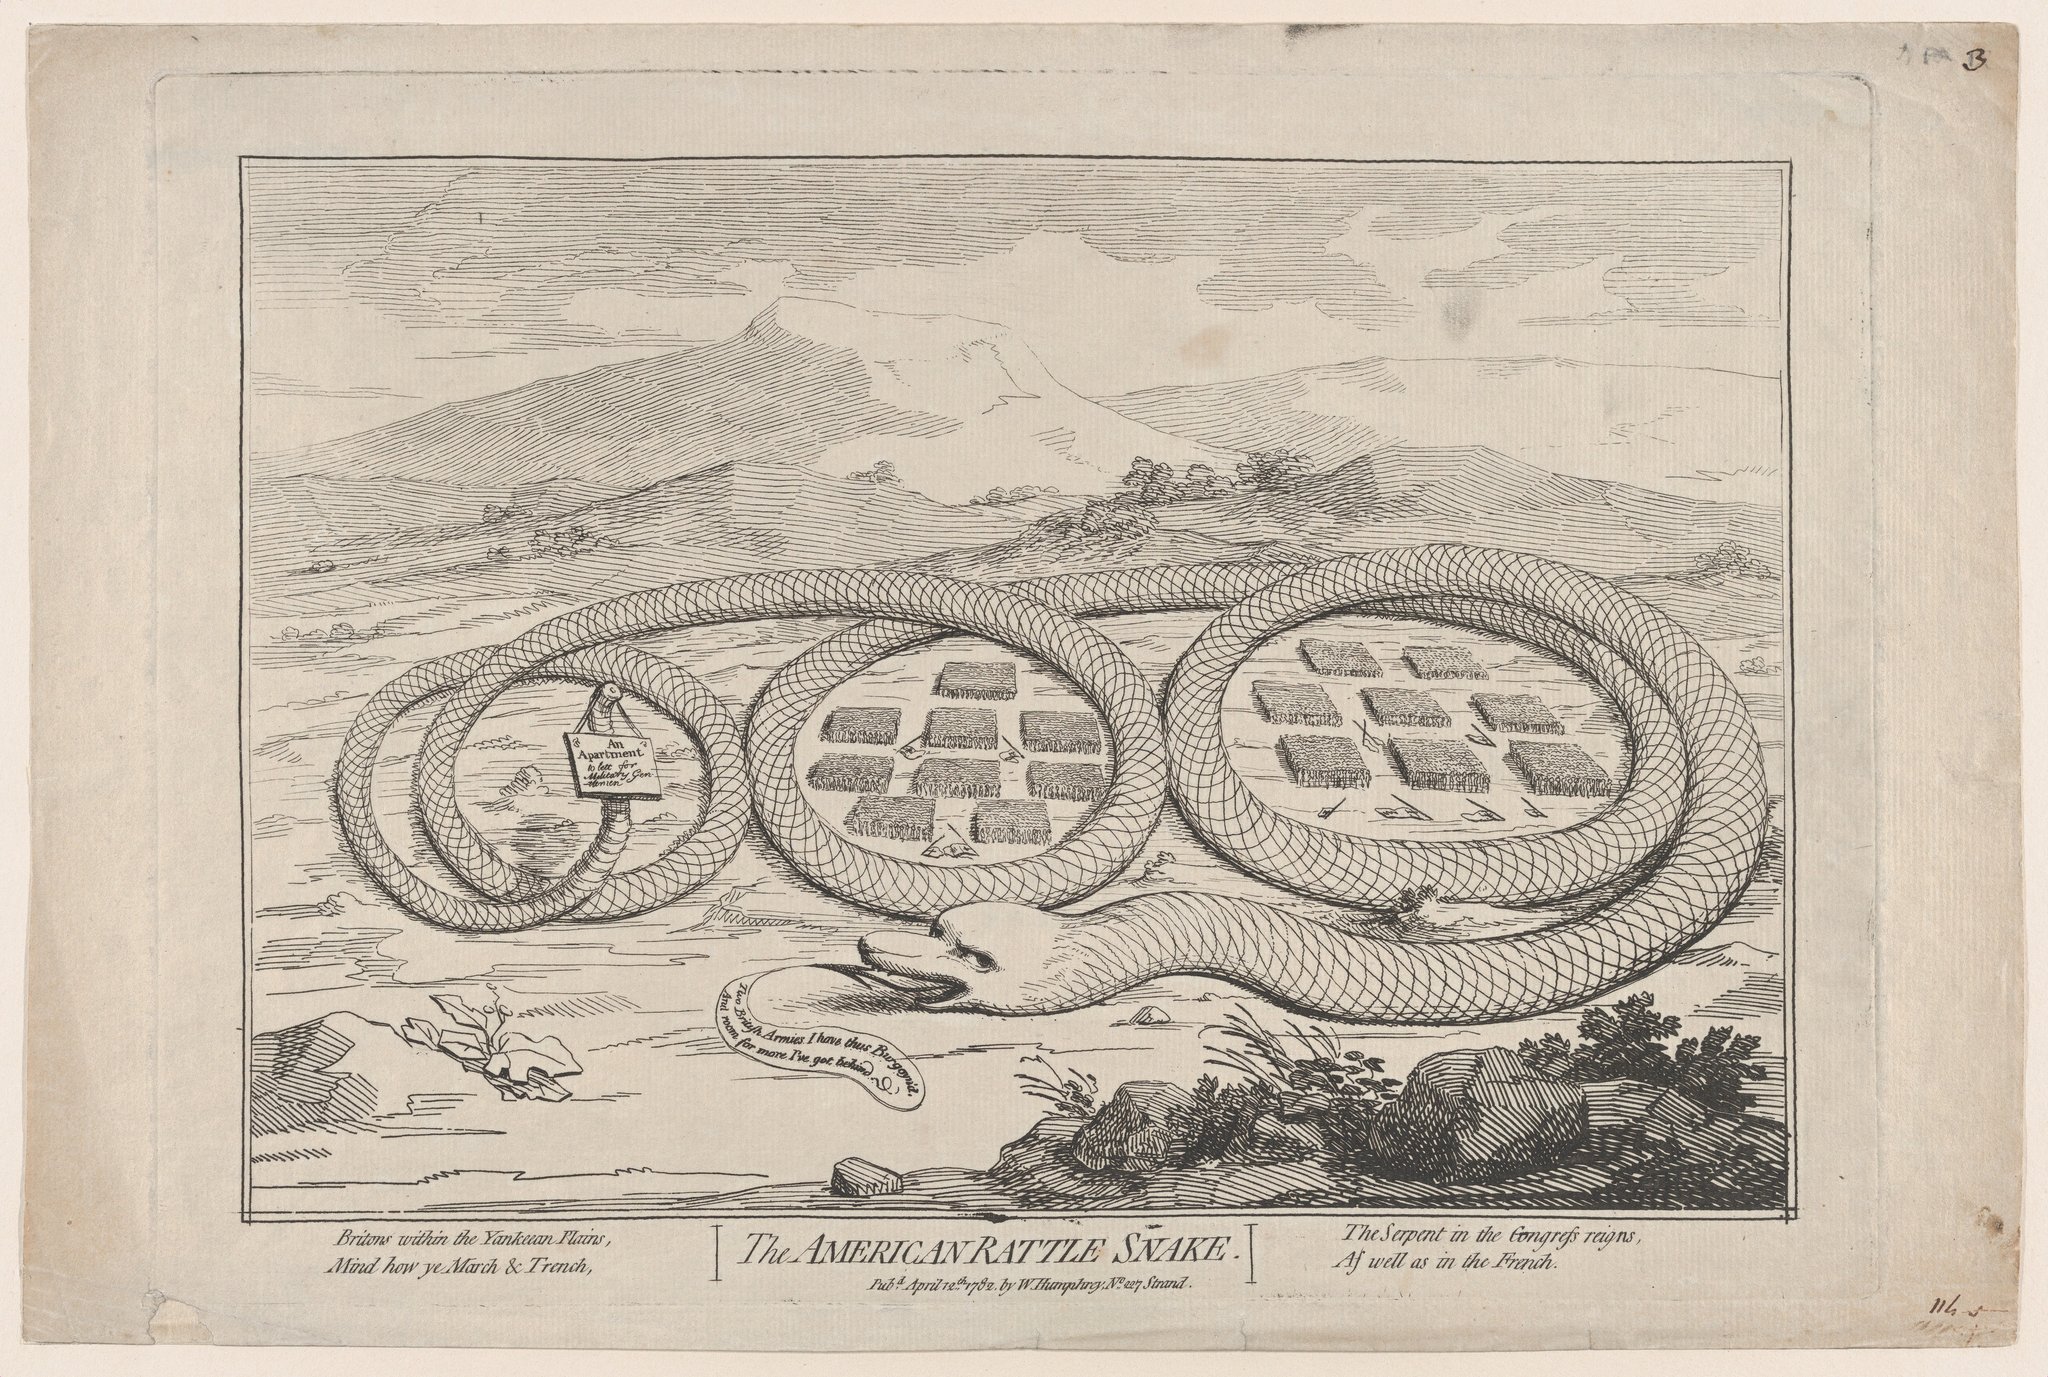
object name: print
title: The American Rattle Snake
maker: james gillray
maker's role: artist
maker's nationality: british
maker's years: 1756-1815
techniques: etching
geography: london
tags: satire,american revolution,snakes,politics